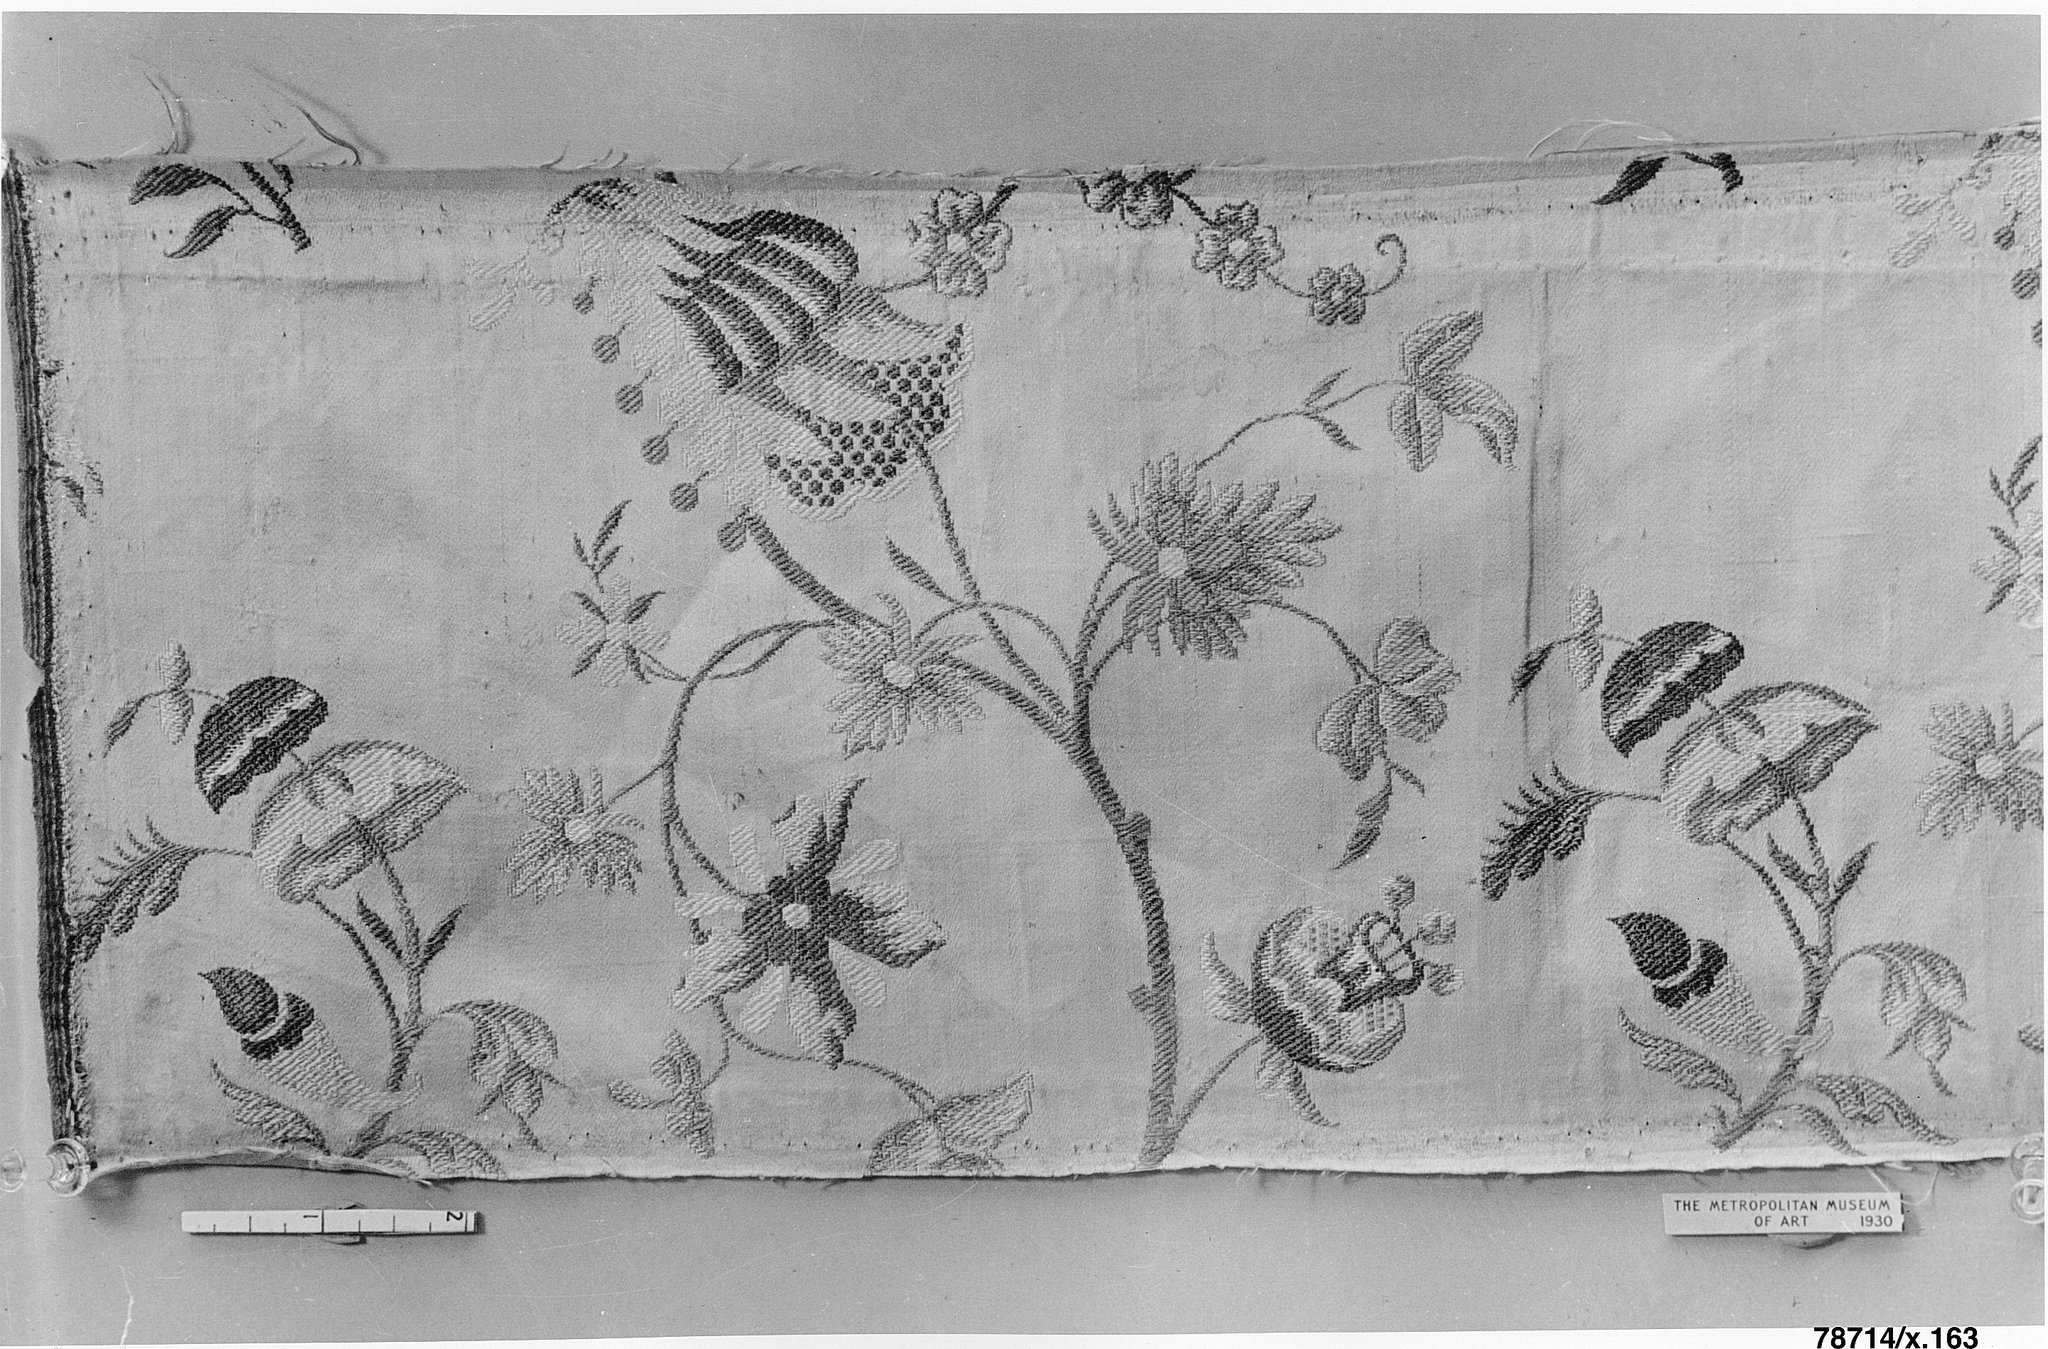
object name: fragment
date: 1701-1800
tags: flowers,leaves